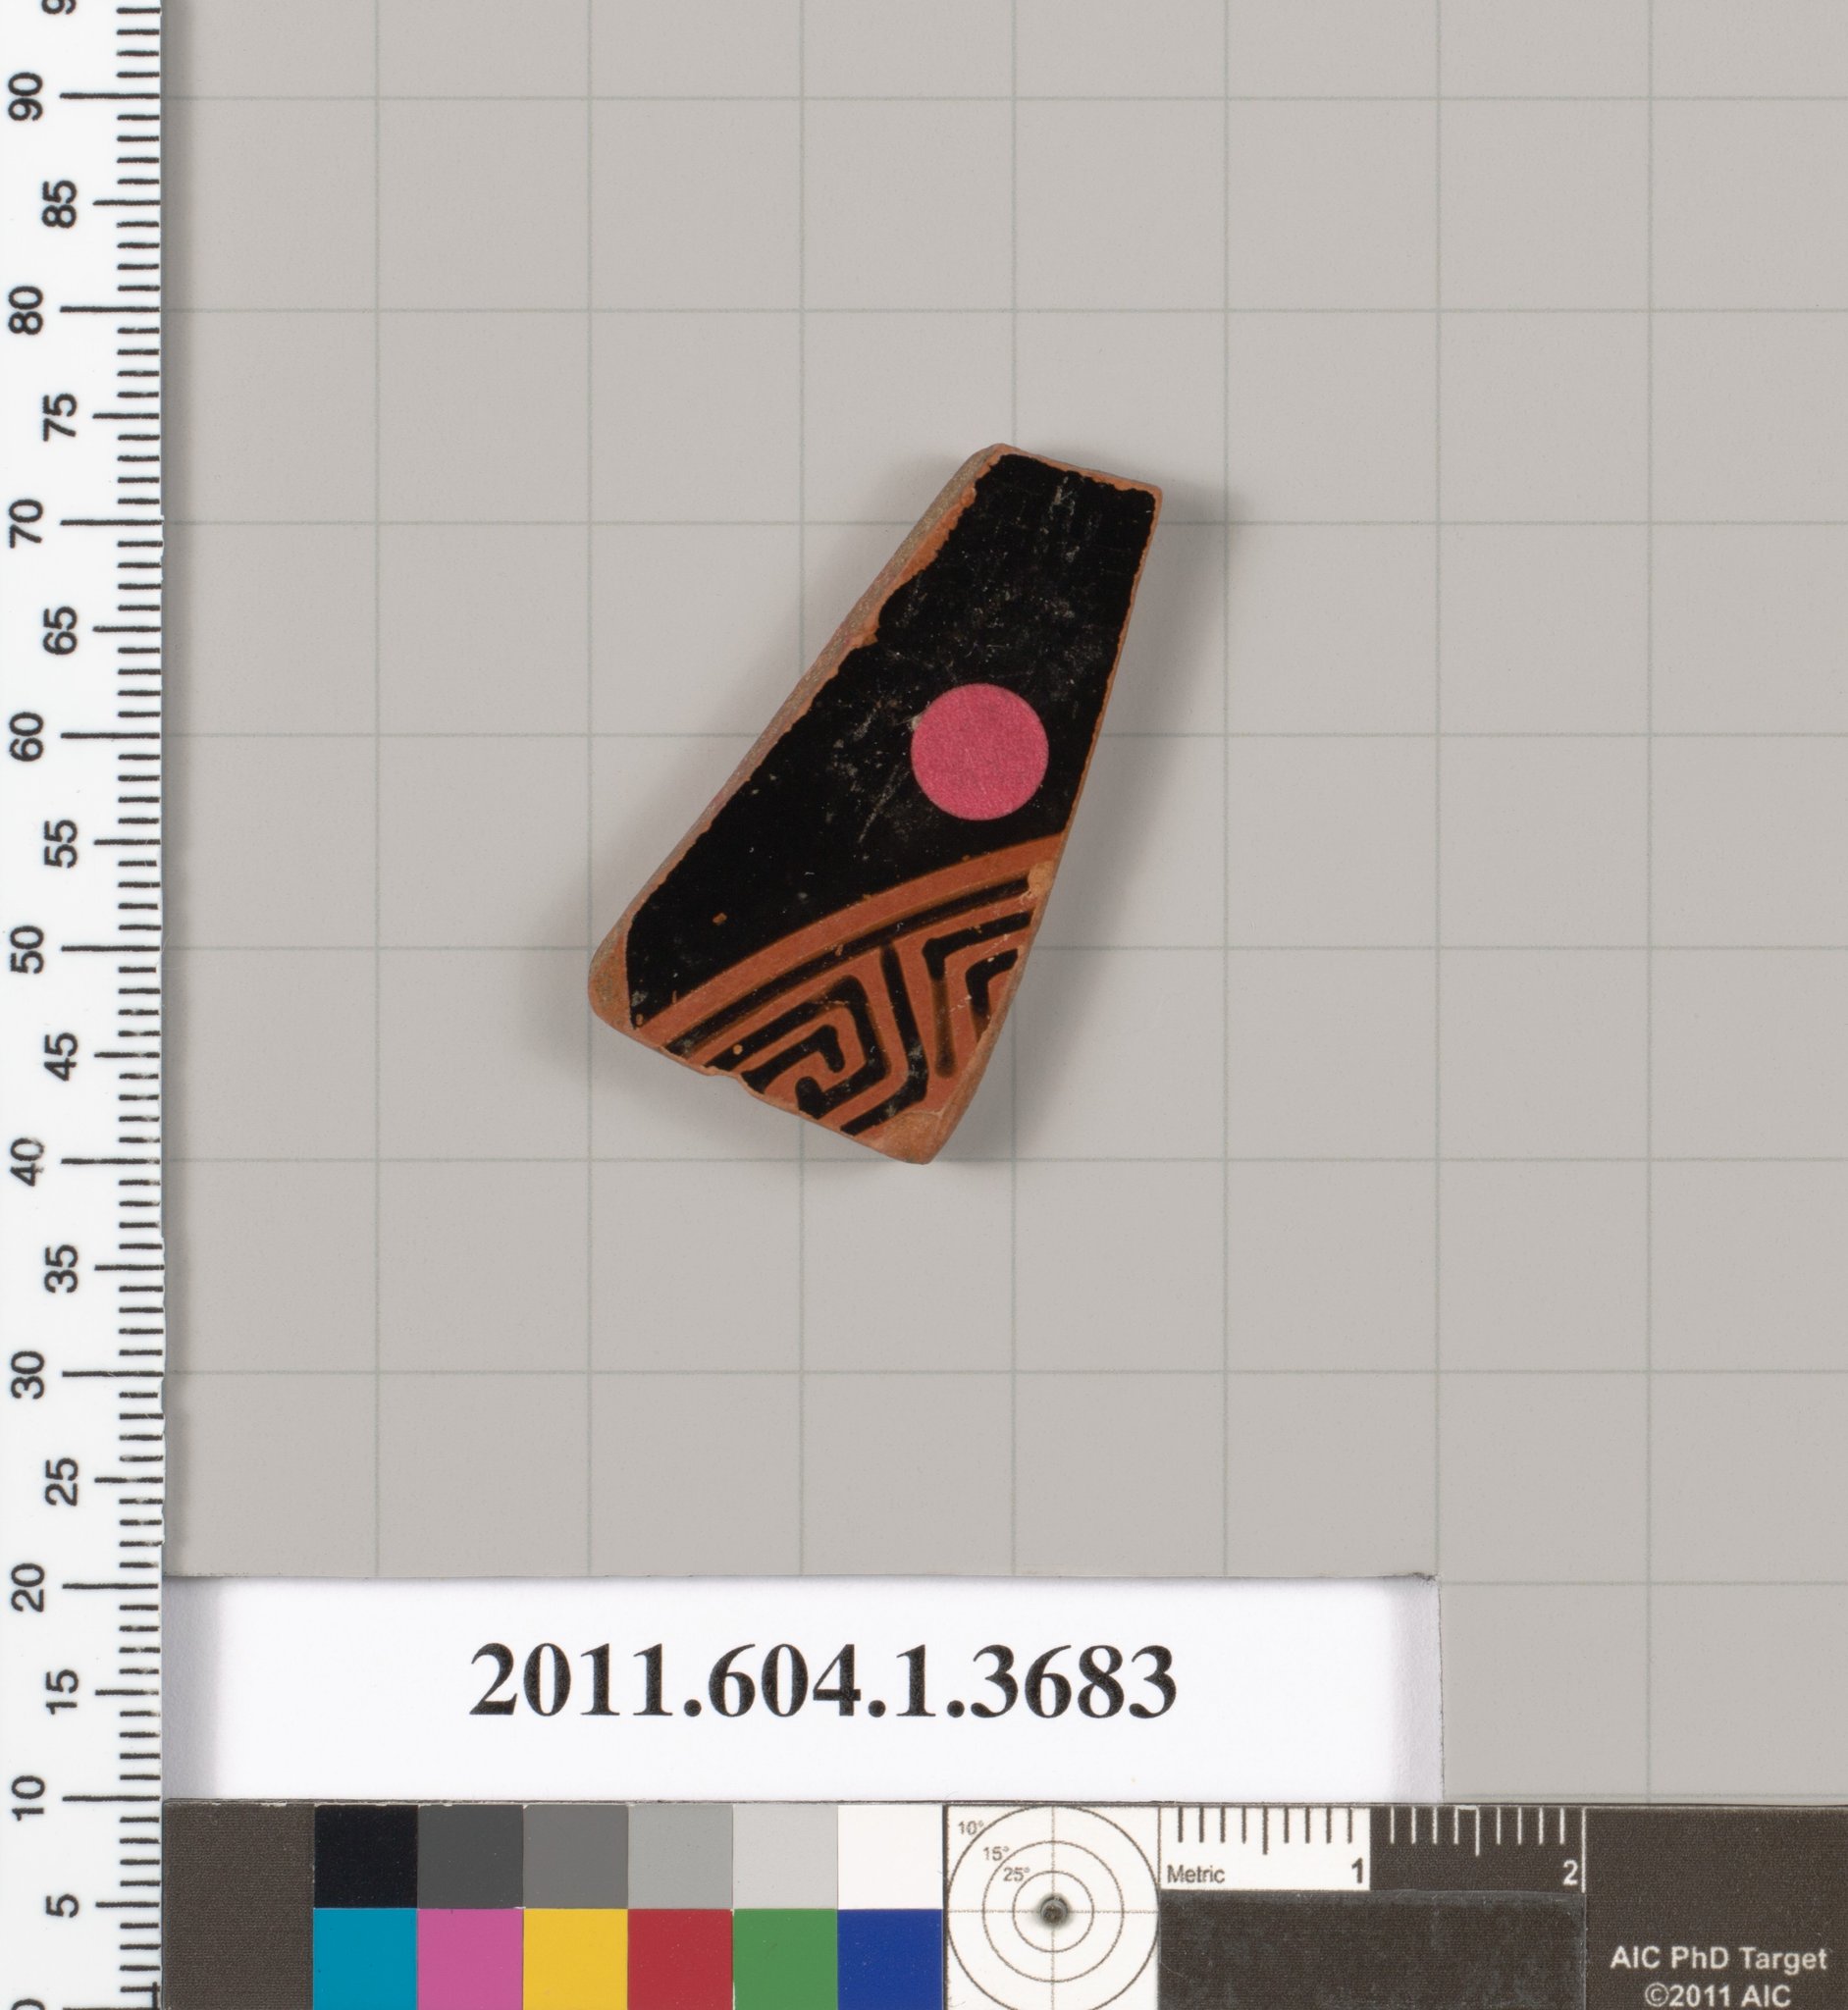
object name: kylix fragment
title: Terracotta fragment of a kylix (drinking cup)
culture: greek, attic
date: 490-480 BCE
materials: terracotta